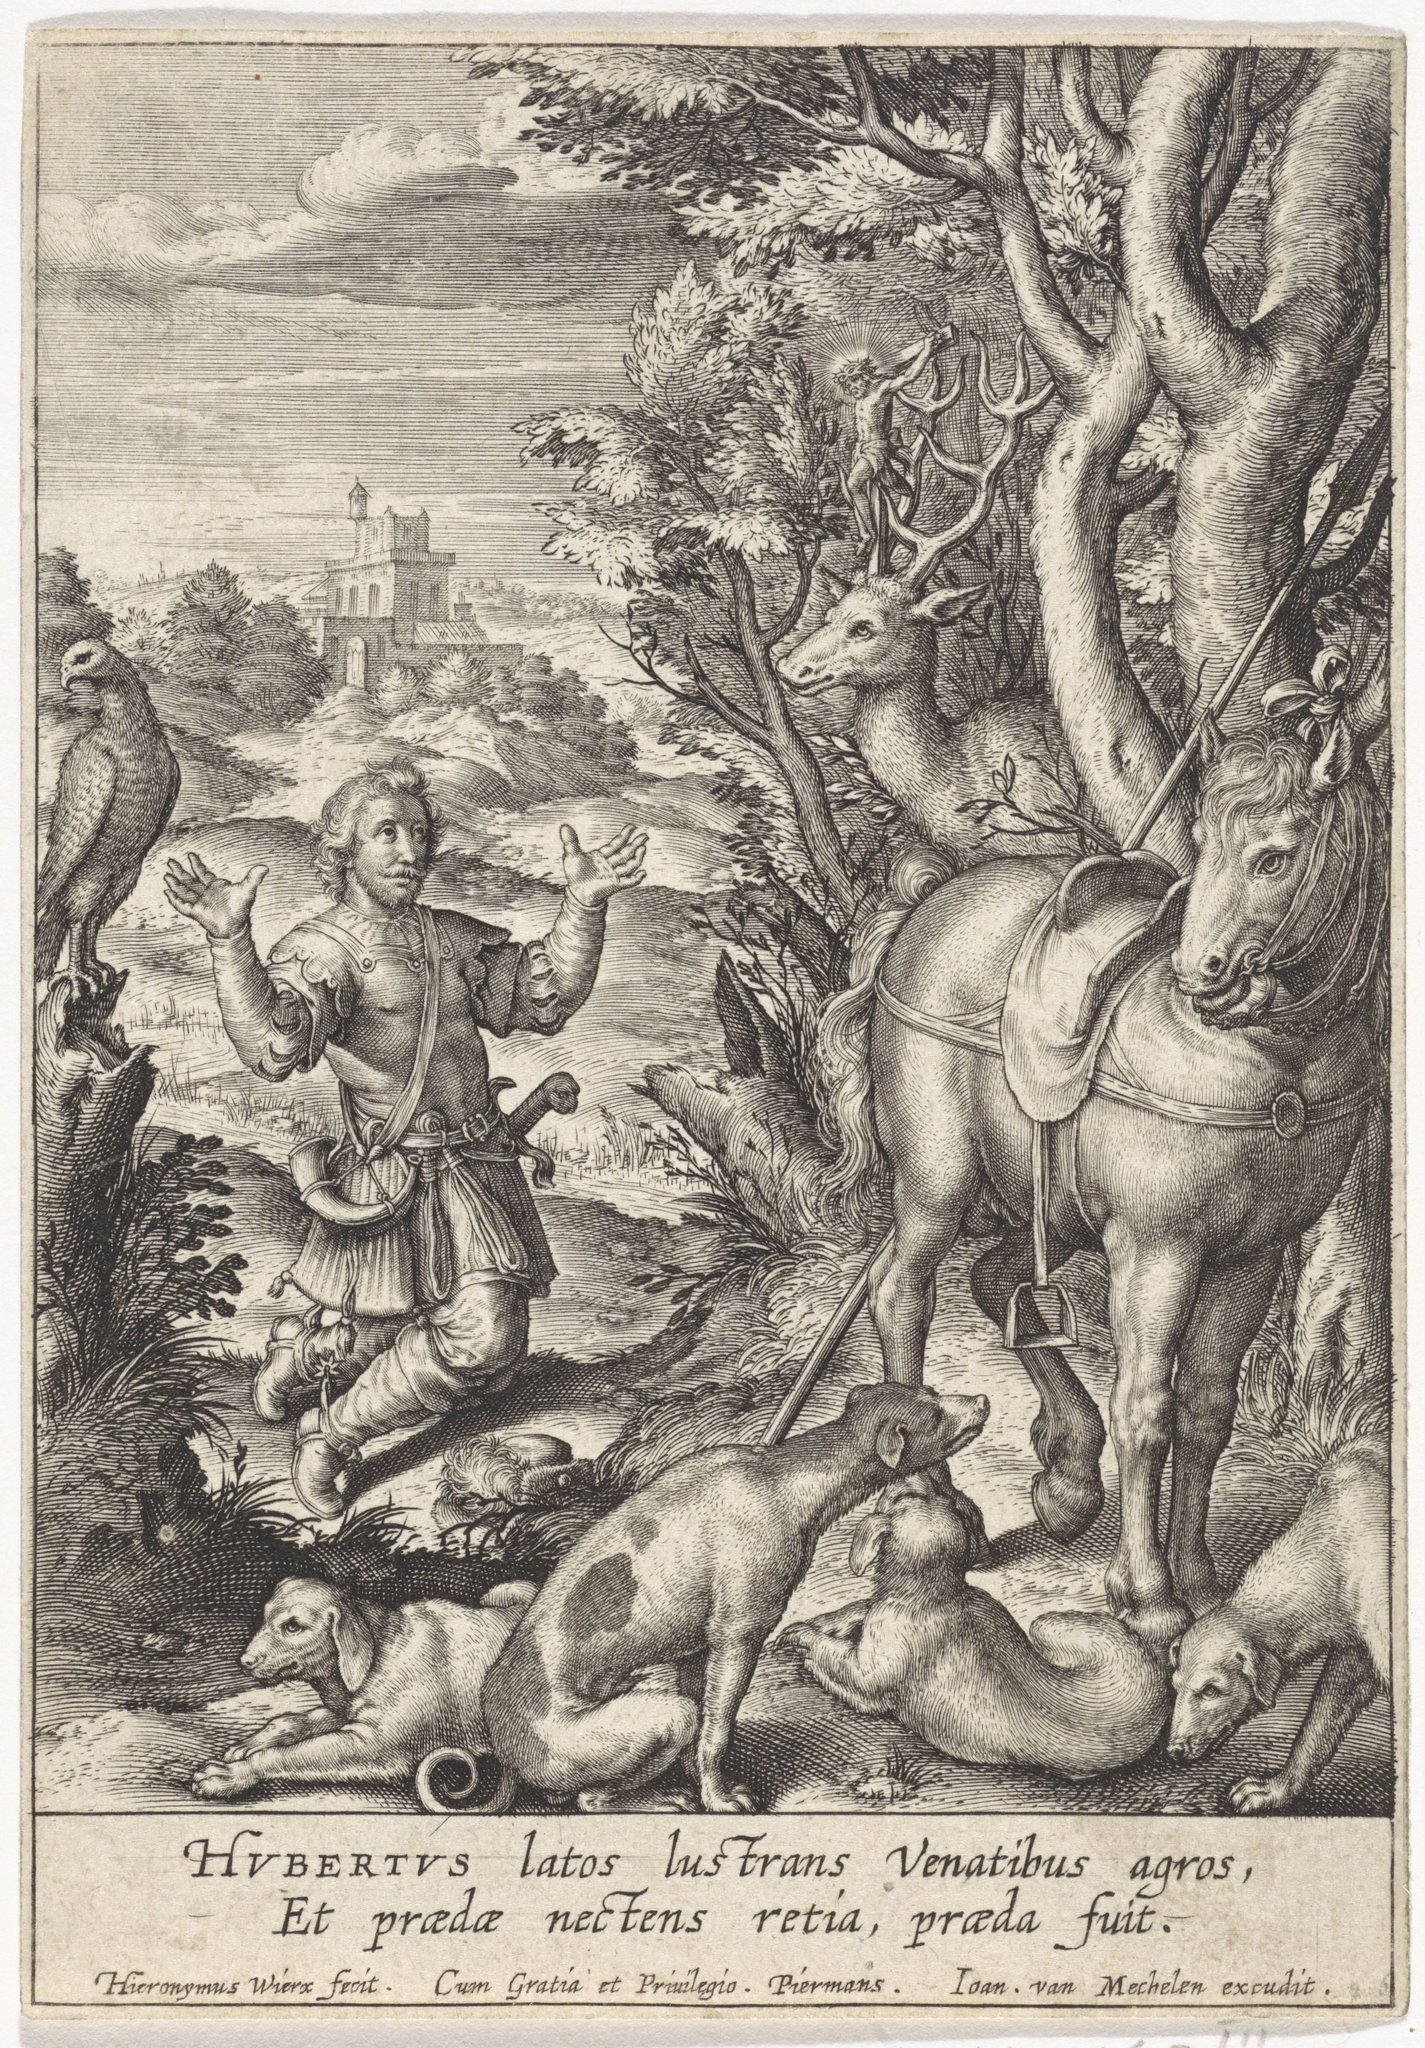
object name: print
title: Bekering van H. Hubertus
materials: paper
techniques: engraving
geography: antwerp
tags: while hunting on good friday st. hubert is confronted with a white stag bearing a crucifix between its antlers; hubert kneels before the stag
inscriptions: inscription: ‘&’, collector's mark: Lugt 2228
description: De heilige Hubertus knielt in het bos voor een hertenbok met een crucifix tussen zijn gewei. Op de boomstam naast hem zit een valk. Op de voorgrond zijn jachthonden, van wie één aan het poepen is. In de marge een tweeregelig onderschrift in het Latijn.